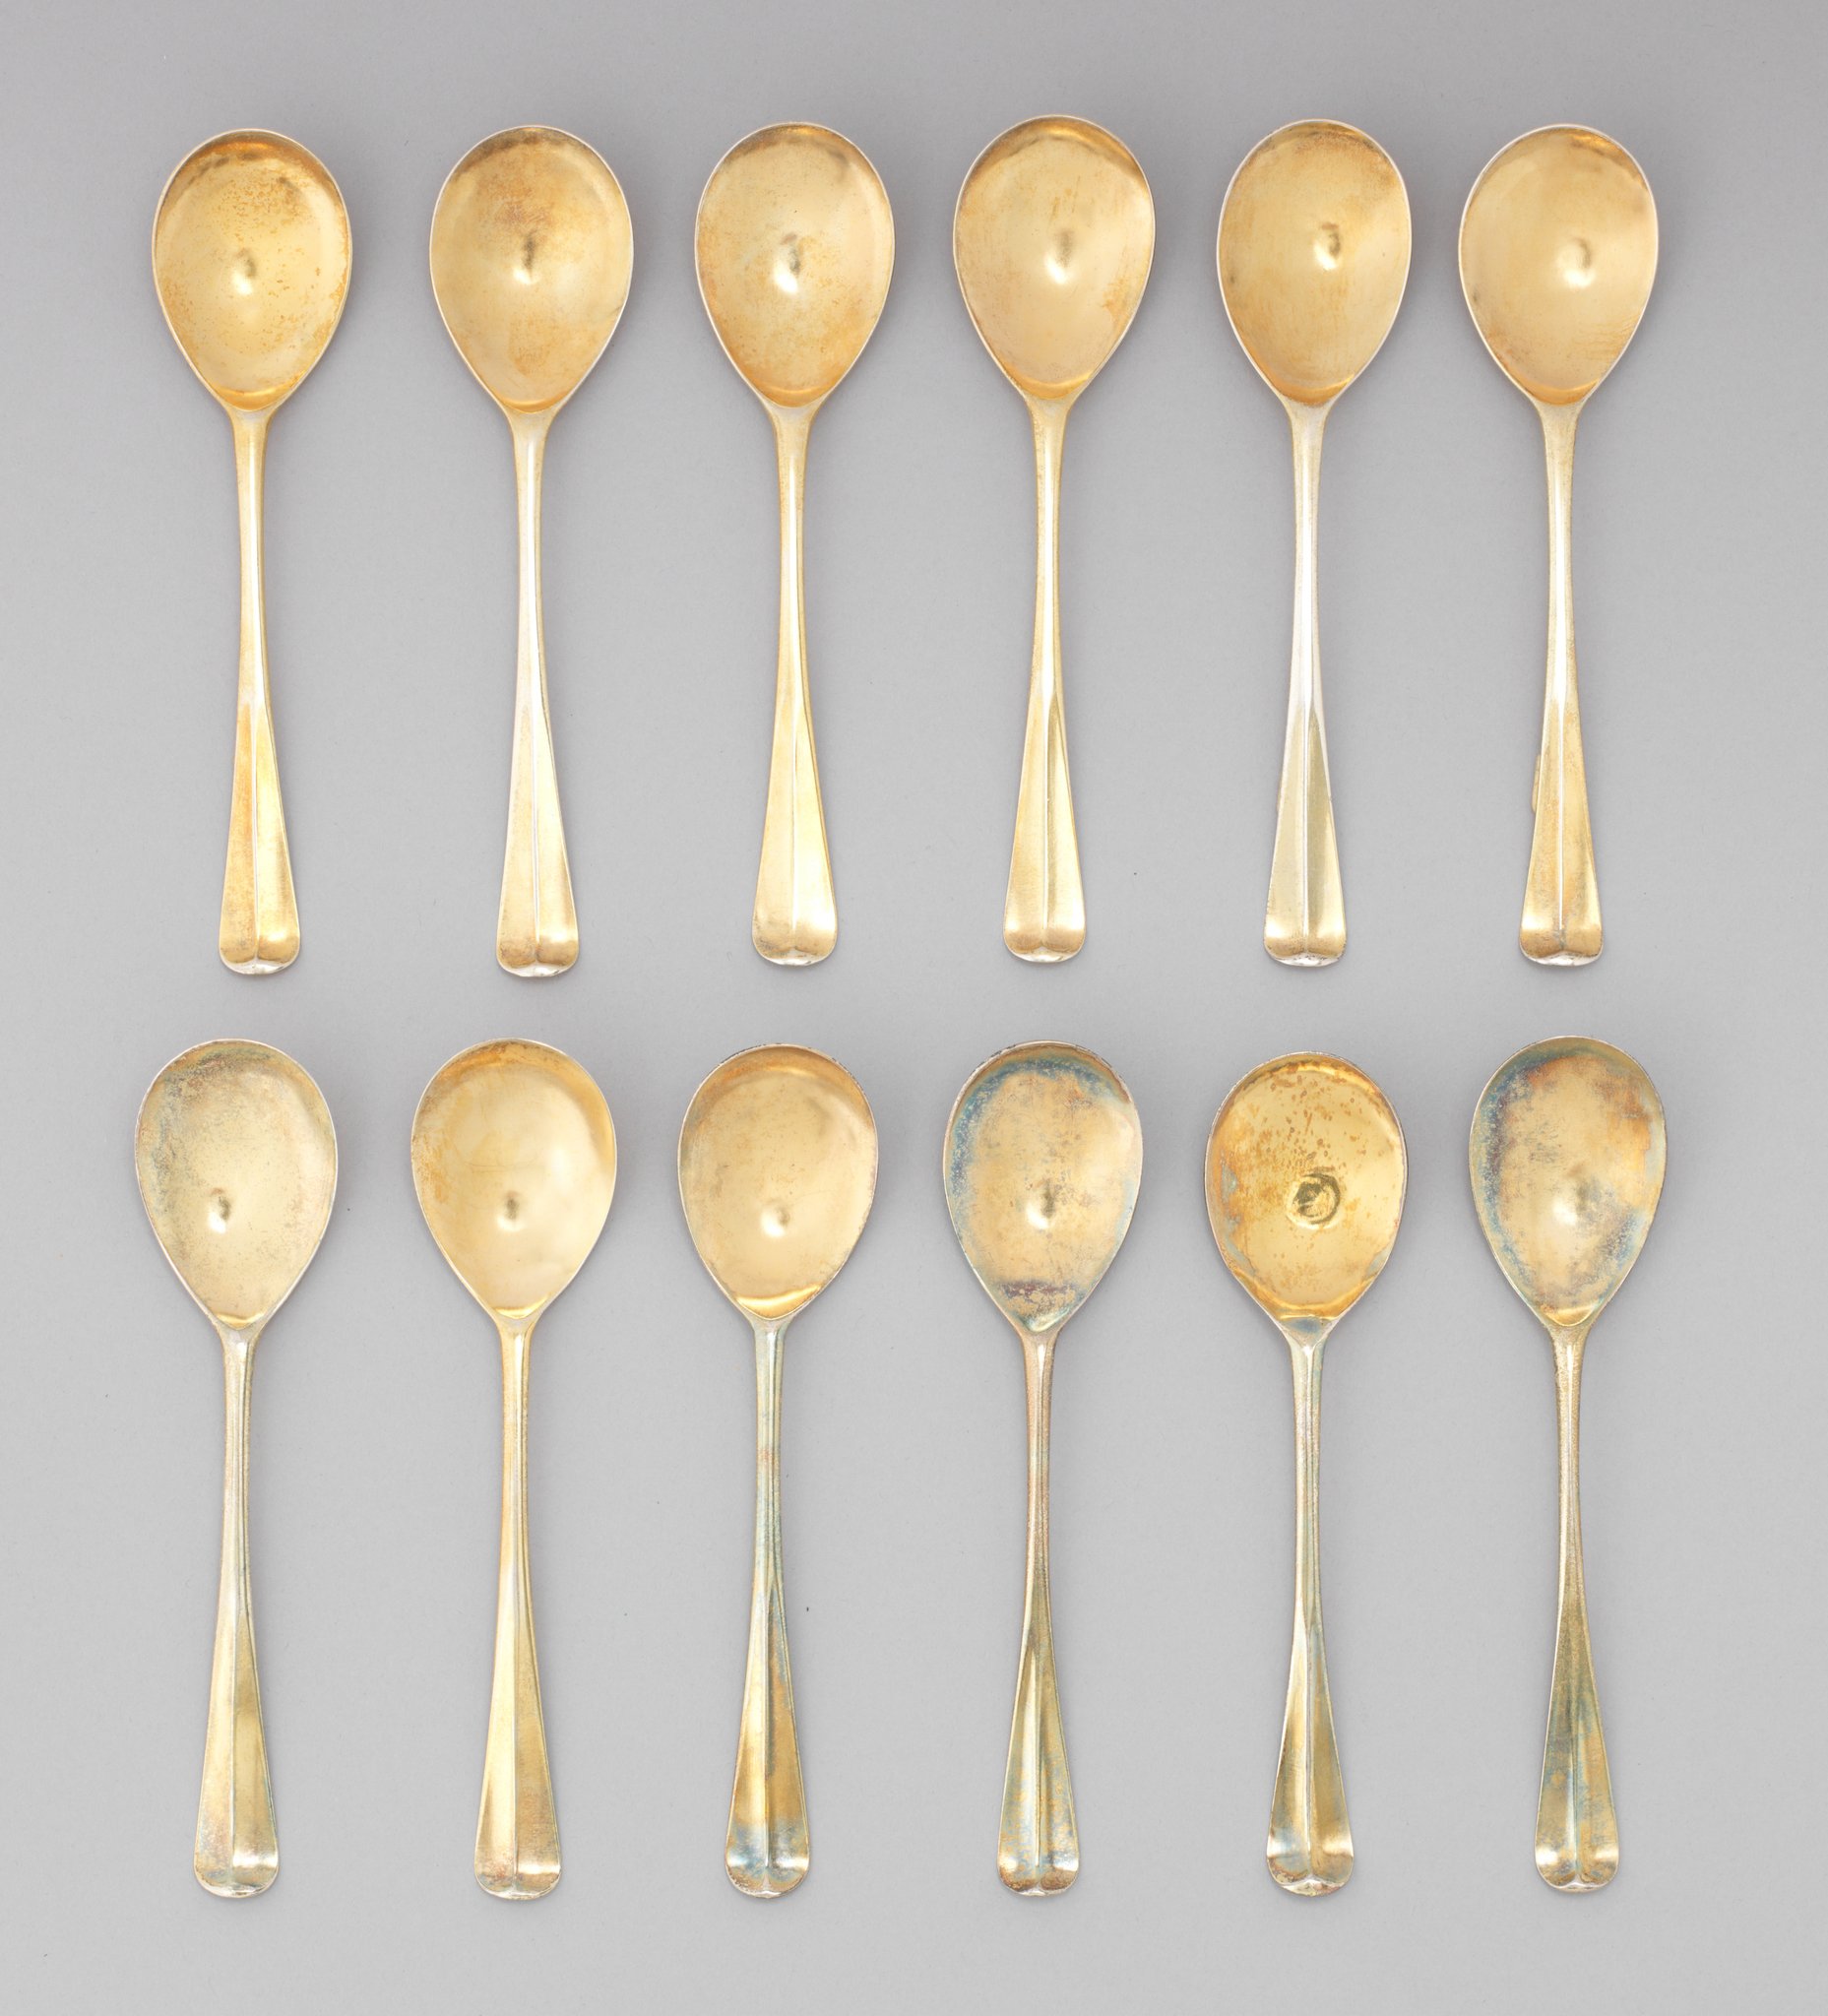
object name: dessert spoon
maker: w.w.(?), dublin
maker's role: maker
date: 1701-1800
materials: silver gilt